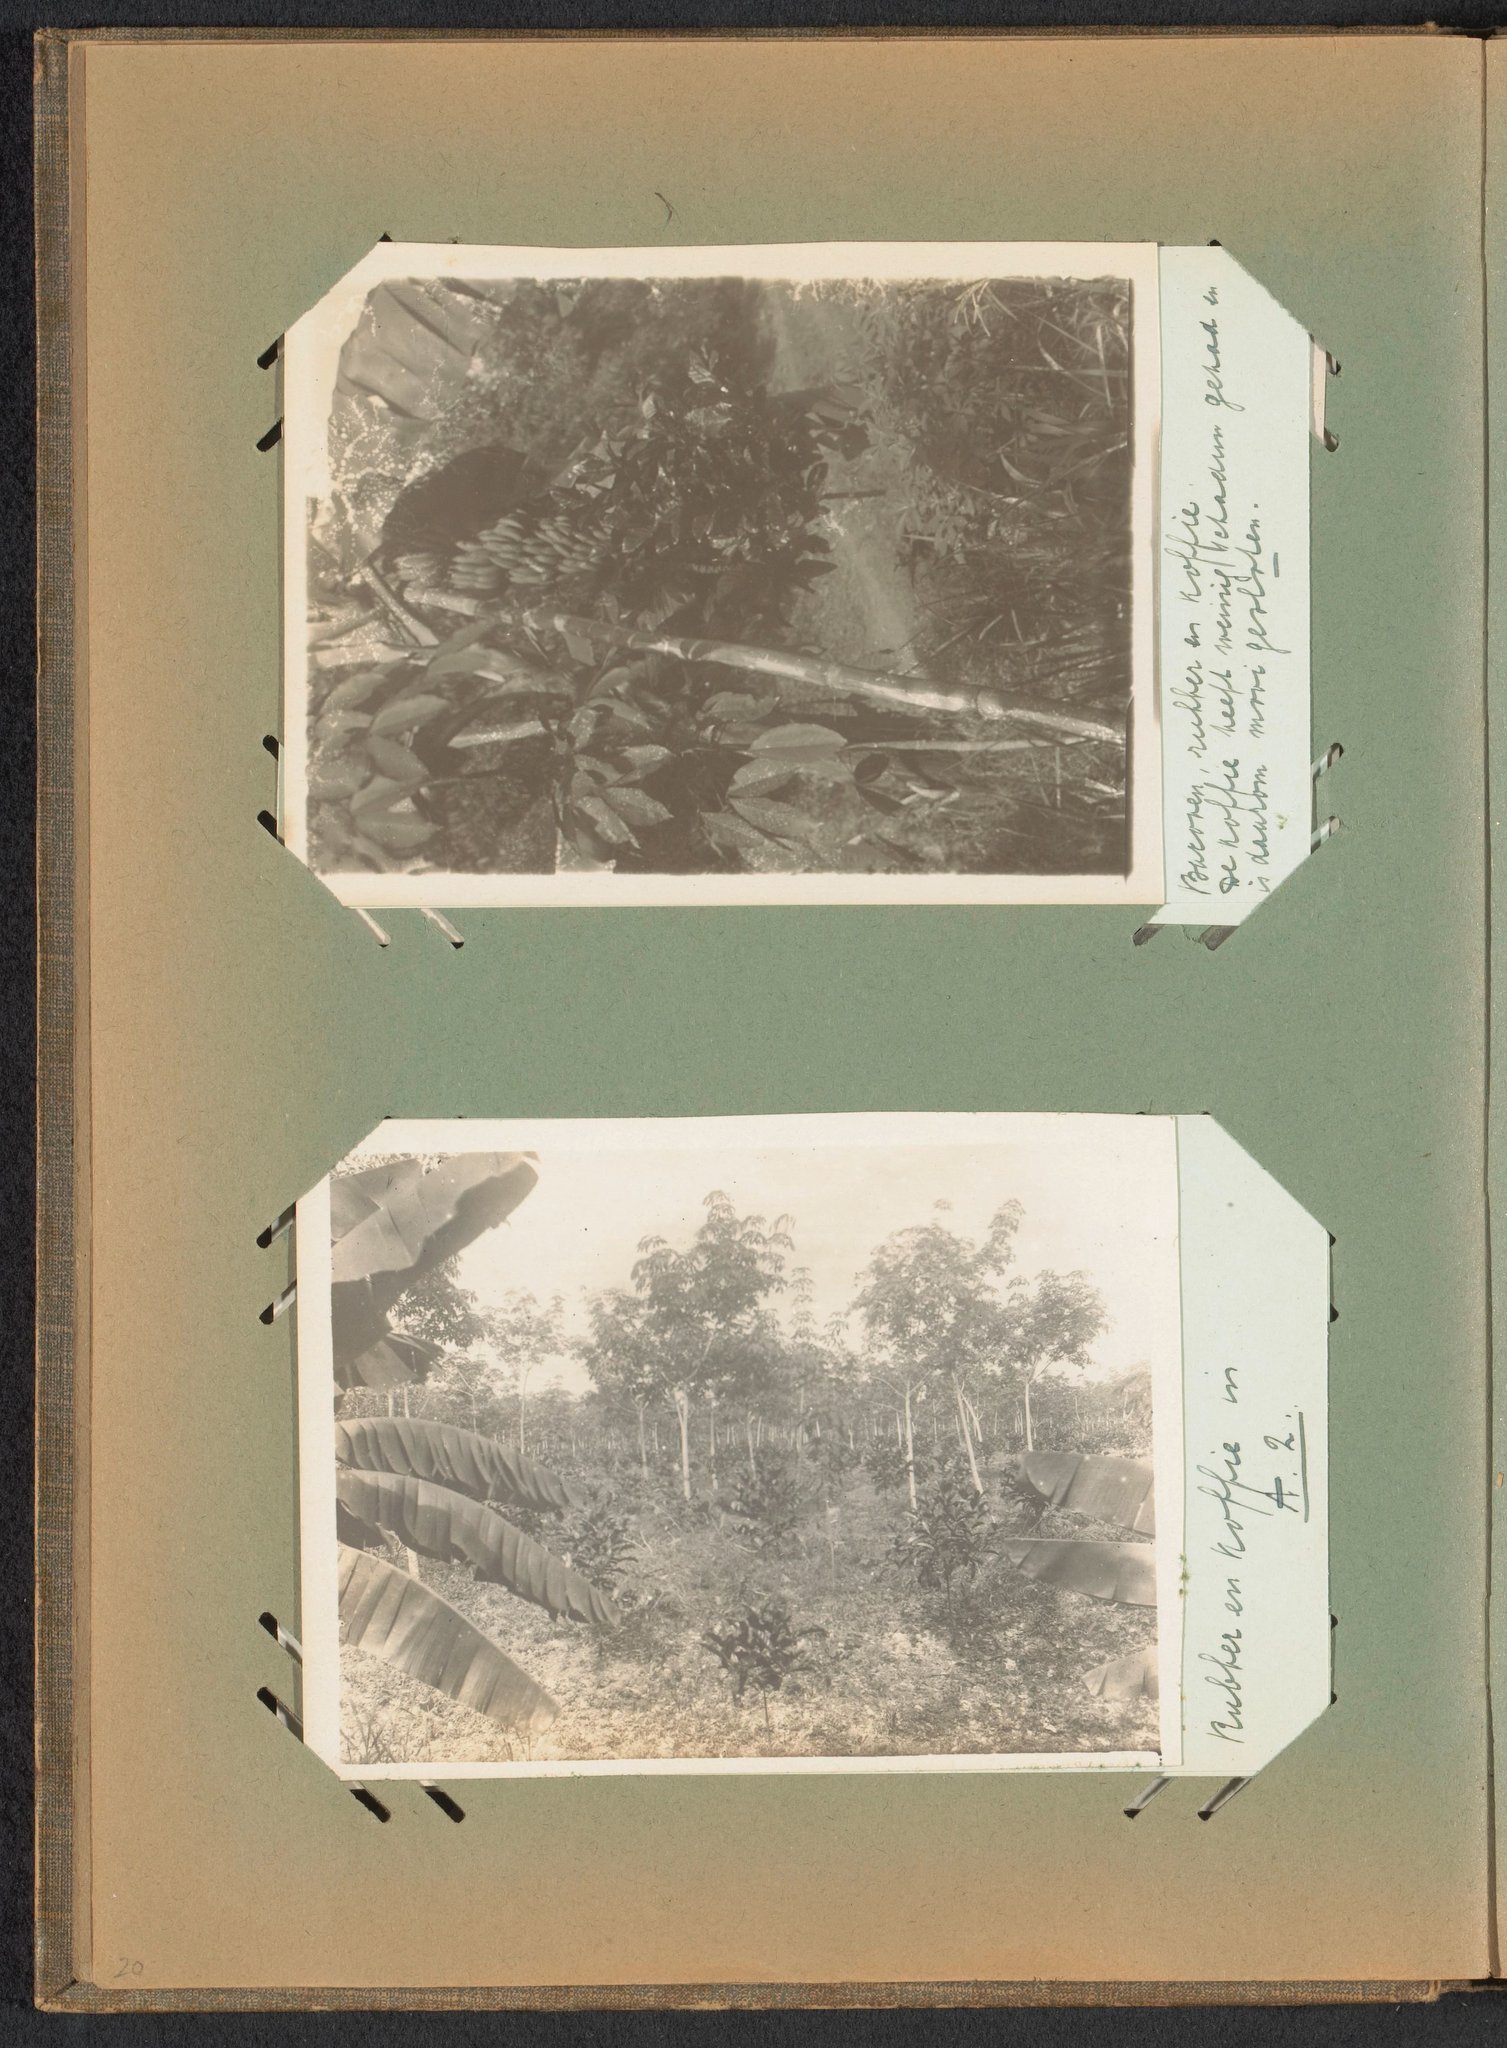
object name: photograph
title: Bananen-, rubber- en koffiebomen op Plantage Peperpot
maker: Anonymous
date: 1912-1913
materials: paper, photographic support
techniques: gelatin silver print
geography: suriname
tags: plantation, fruits: banana, (non-fruit) products of plants or trees: rubber, fruits: coffee, suriname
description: Bananen-, rubber- en koffiebomen op Plantage Peperpot Suriname. Onderdeel van het fotoalbum uit ca. 1912-1913 met 92 foto's van de plantages Peperpot en Dordrecht in Suriname en Mount Pleasant op Curaçao.